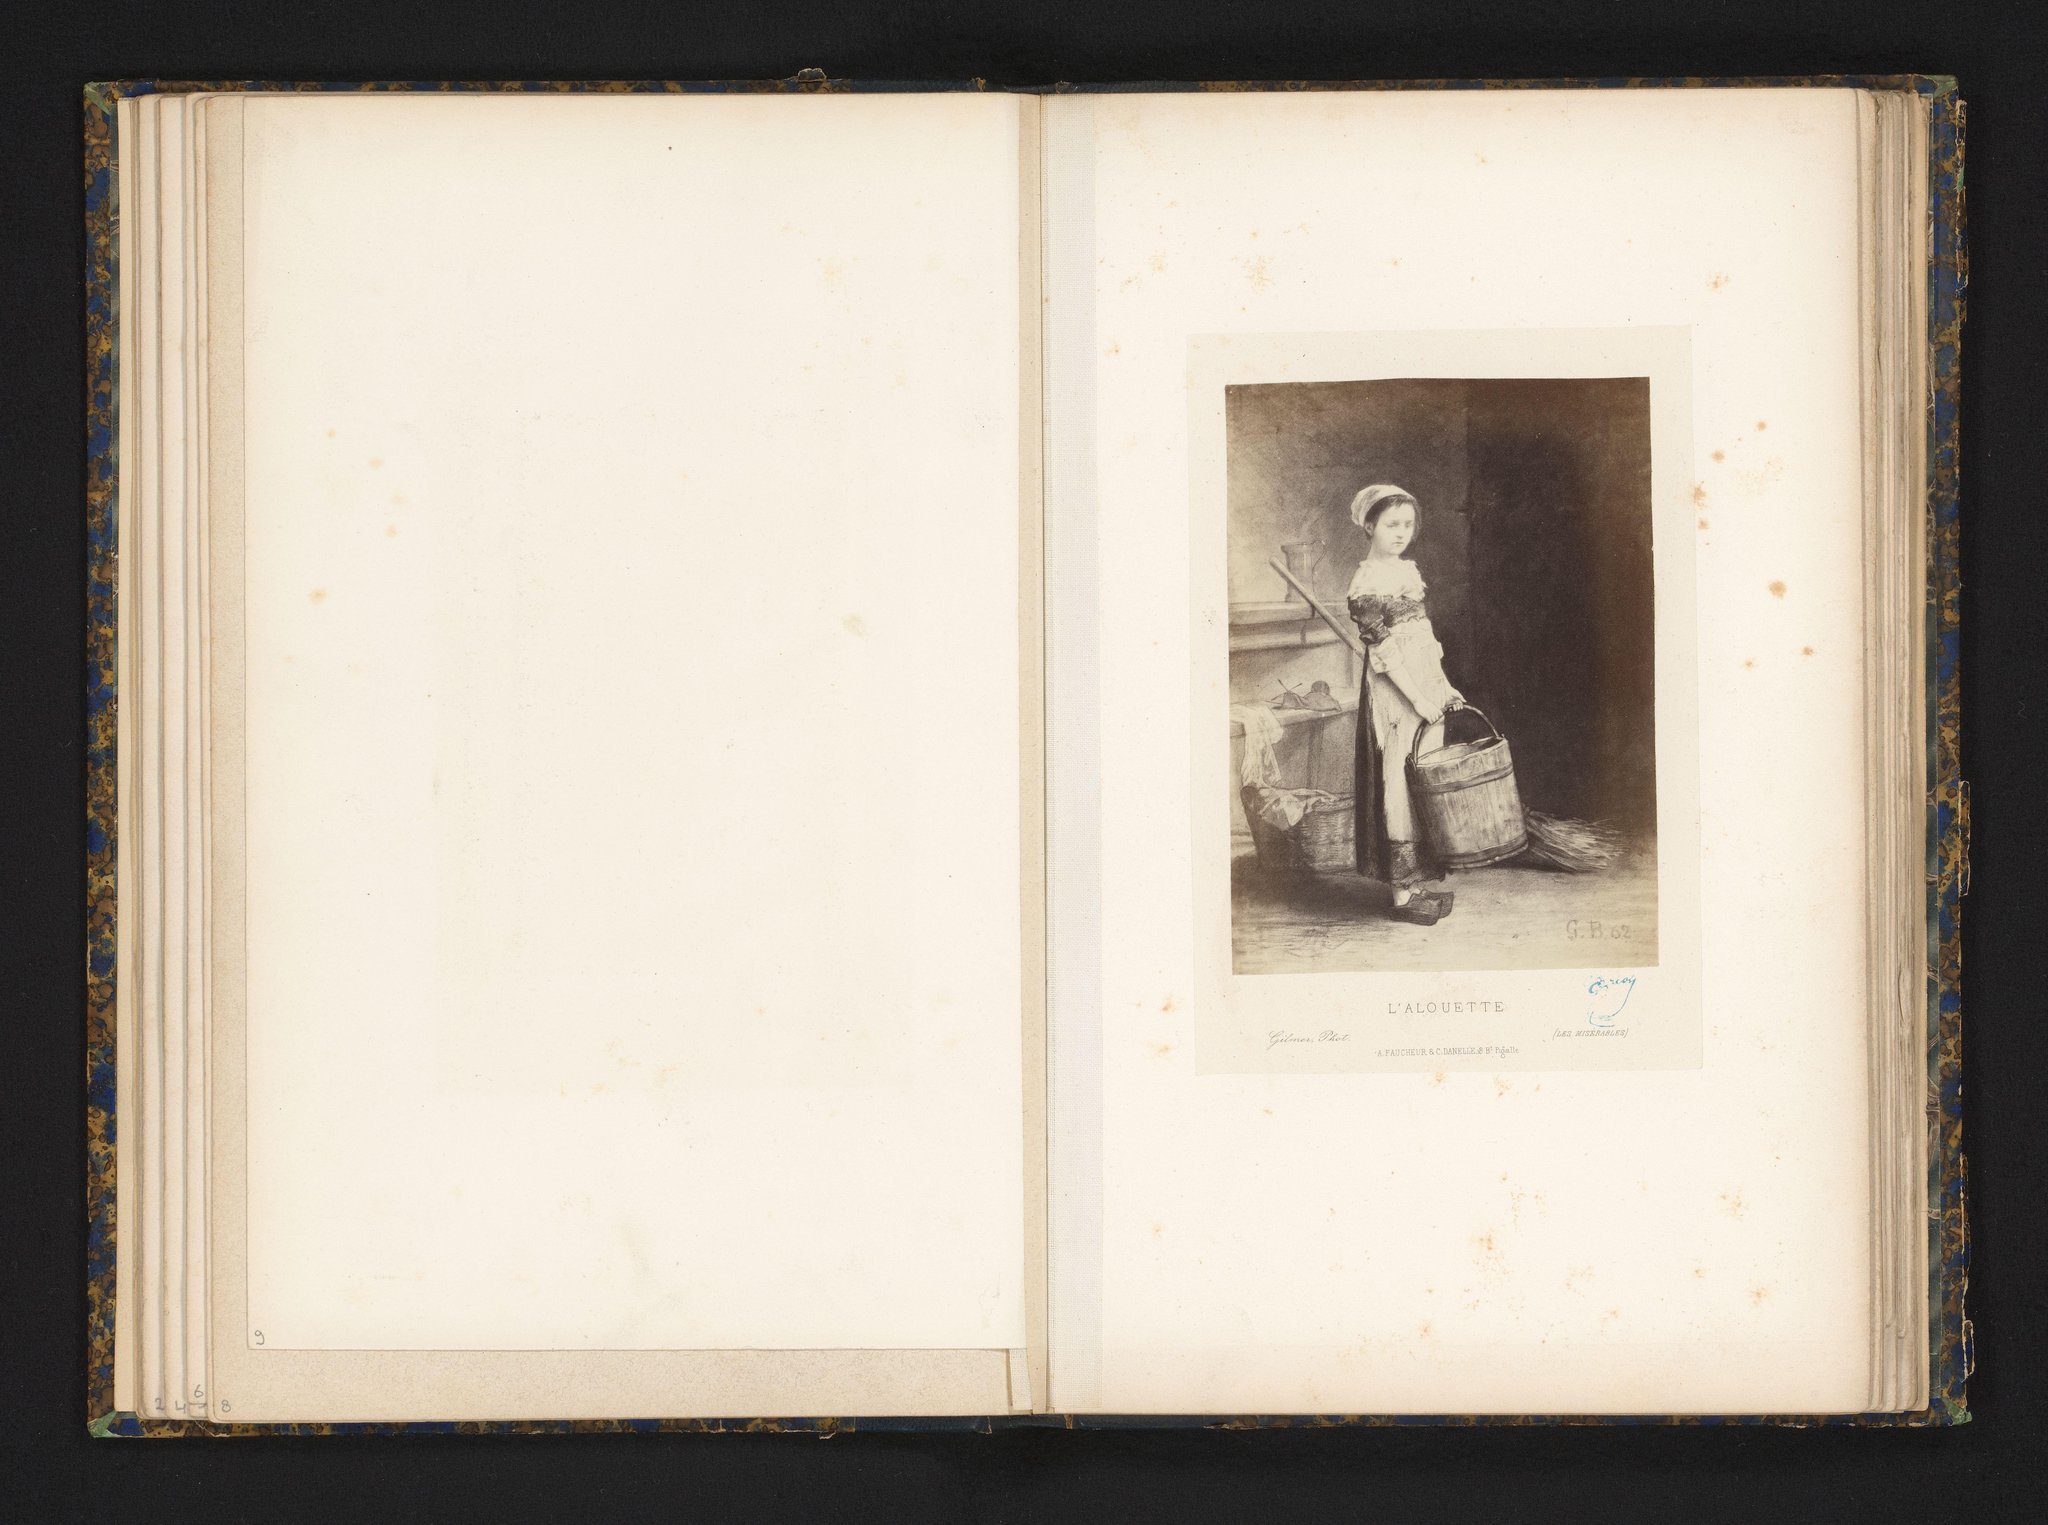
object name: photograph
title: L'Alouette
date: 1862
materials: photographic support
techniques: albumen print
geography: paris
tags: literary characters and objects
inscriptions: inscription: ‘(LES MISÉRABLES)’, address: ‘A. FAUCHEUR & C. DANELLE, 18 Bt. Pigalle.’